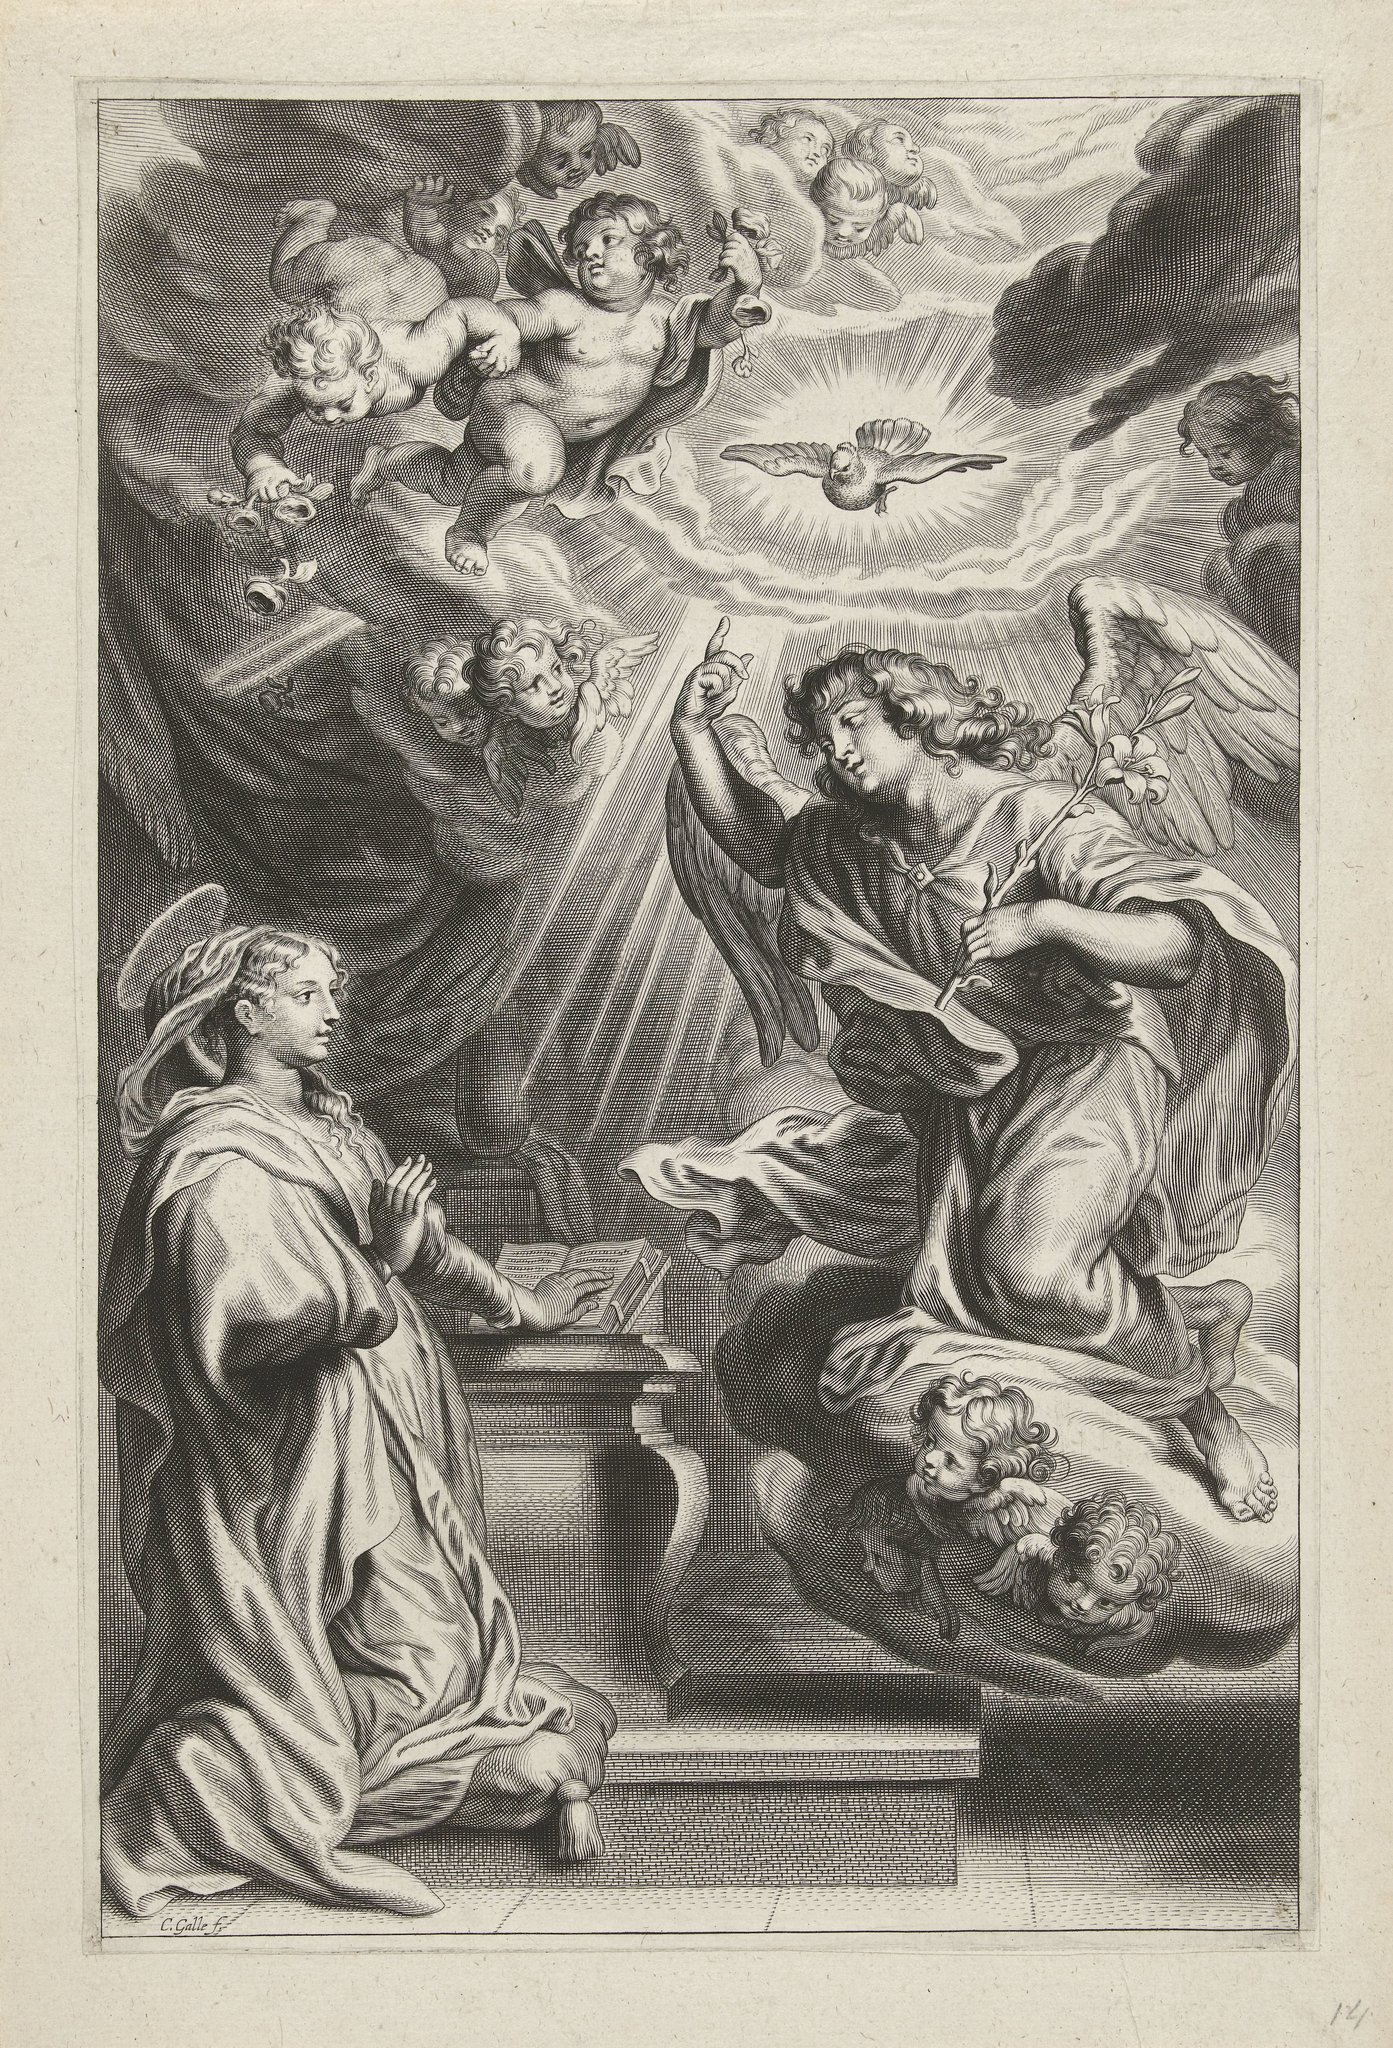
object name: book illustration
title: Annunciatie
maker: cornelis galle (ii)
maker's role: print maker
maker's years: 1615-1678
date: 1650-1653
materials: paper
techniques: engraving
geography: antwerp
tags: the annunciation: mary, usually reading, is visited by the angel (sometimes a woman overhears the conversation)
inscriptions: collector's mark: Lugt 240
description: Maria knielt voor een lessenaar, haar vinger in een boek. De engel verkondigt haar de geboorte van haar zoon. Hij wijst op de Heilige Geest in de gedaante van een duif die boven hem zweeft. Engelen strooien rozenblaadjes op Maria.